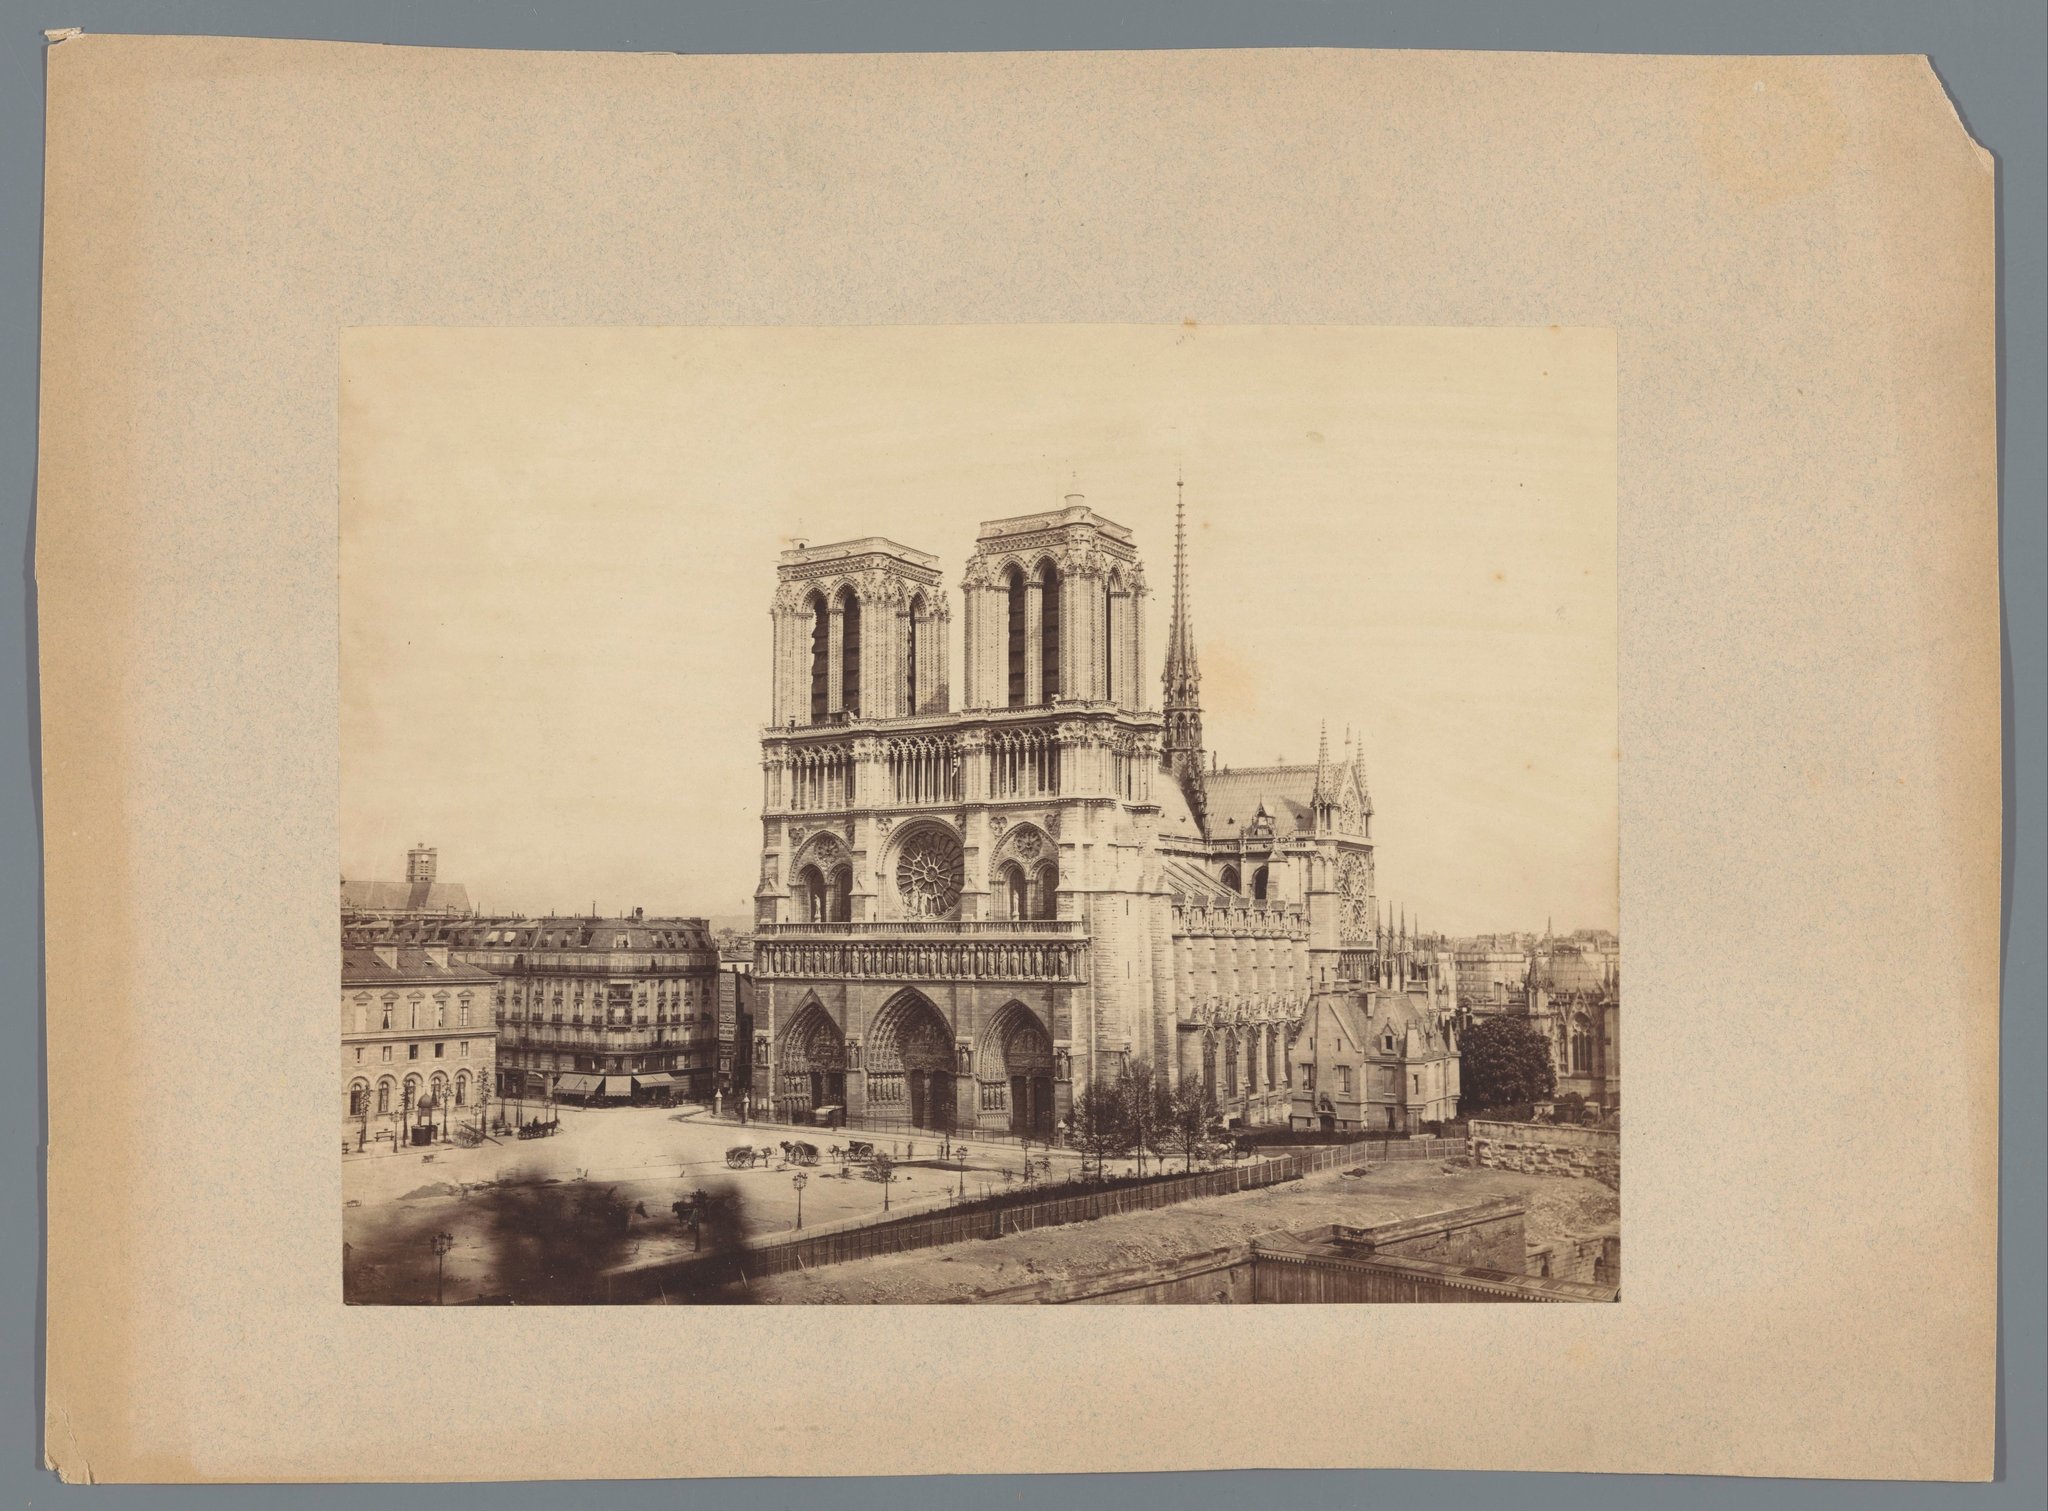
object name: photograph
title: Gezicht op de Notre-Dame te Parijs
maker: Anonymous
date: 1875-1900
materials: cardboard, photographic support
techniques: albumen print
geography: paris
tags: tower, clock tower ~ monumental adornment, church (exterior)